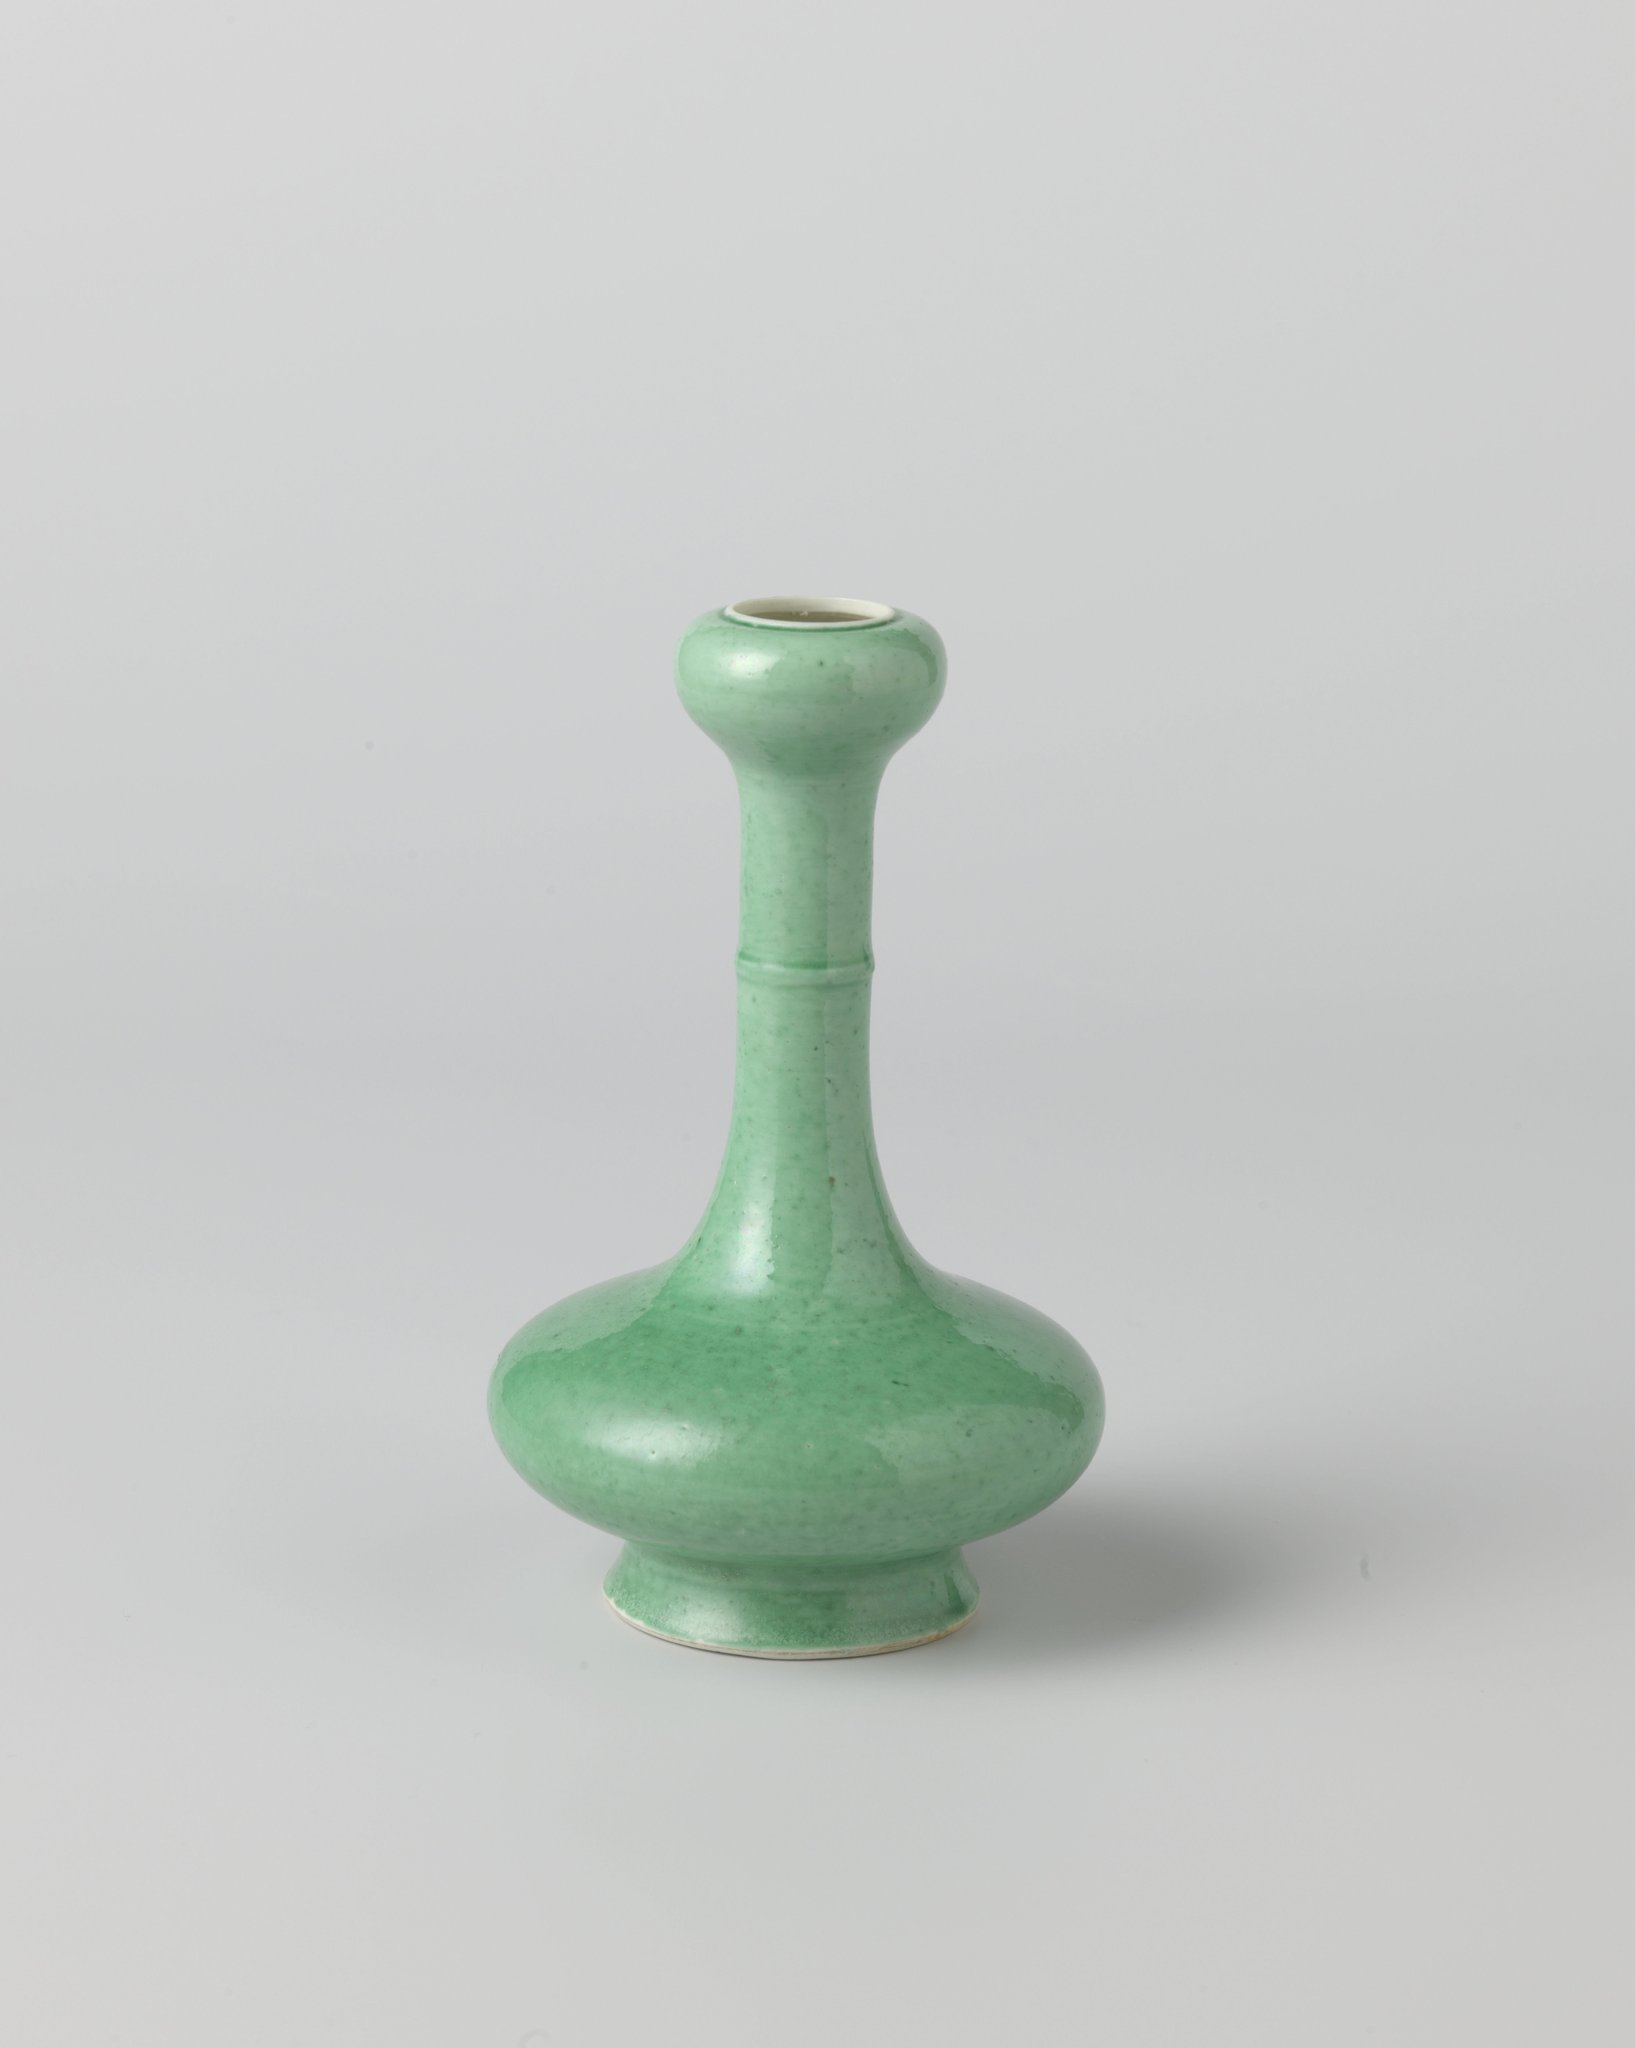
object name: vase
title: Green Bottle Vase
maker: Anonymous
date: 1700-1724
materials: glaze, porcelain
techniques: firing, turning, vitrification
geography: china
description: The green colour derives from copper and lead oxides. This colour was used in Jingdezhen from around 1550, but was initially dark and ran unevenly over the surface. In the 18th century a uniform fresh, apple green colour was achieved. It was made opaque through the addition of tin oxide.